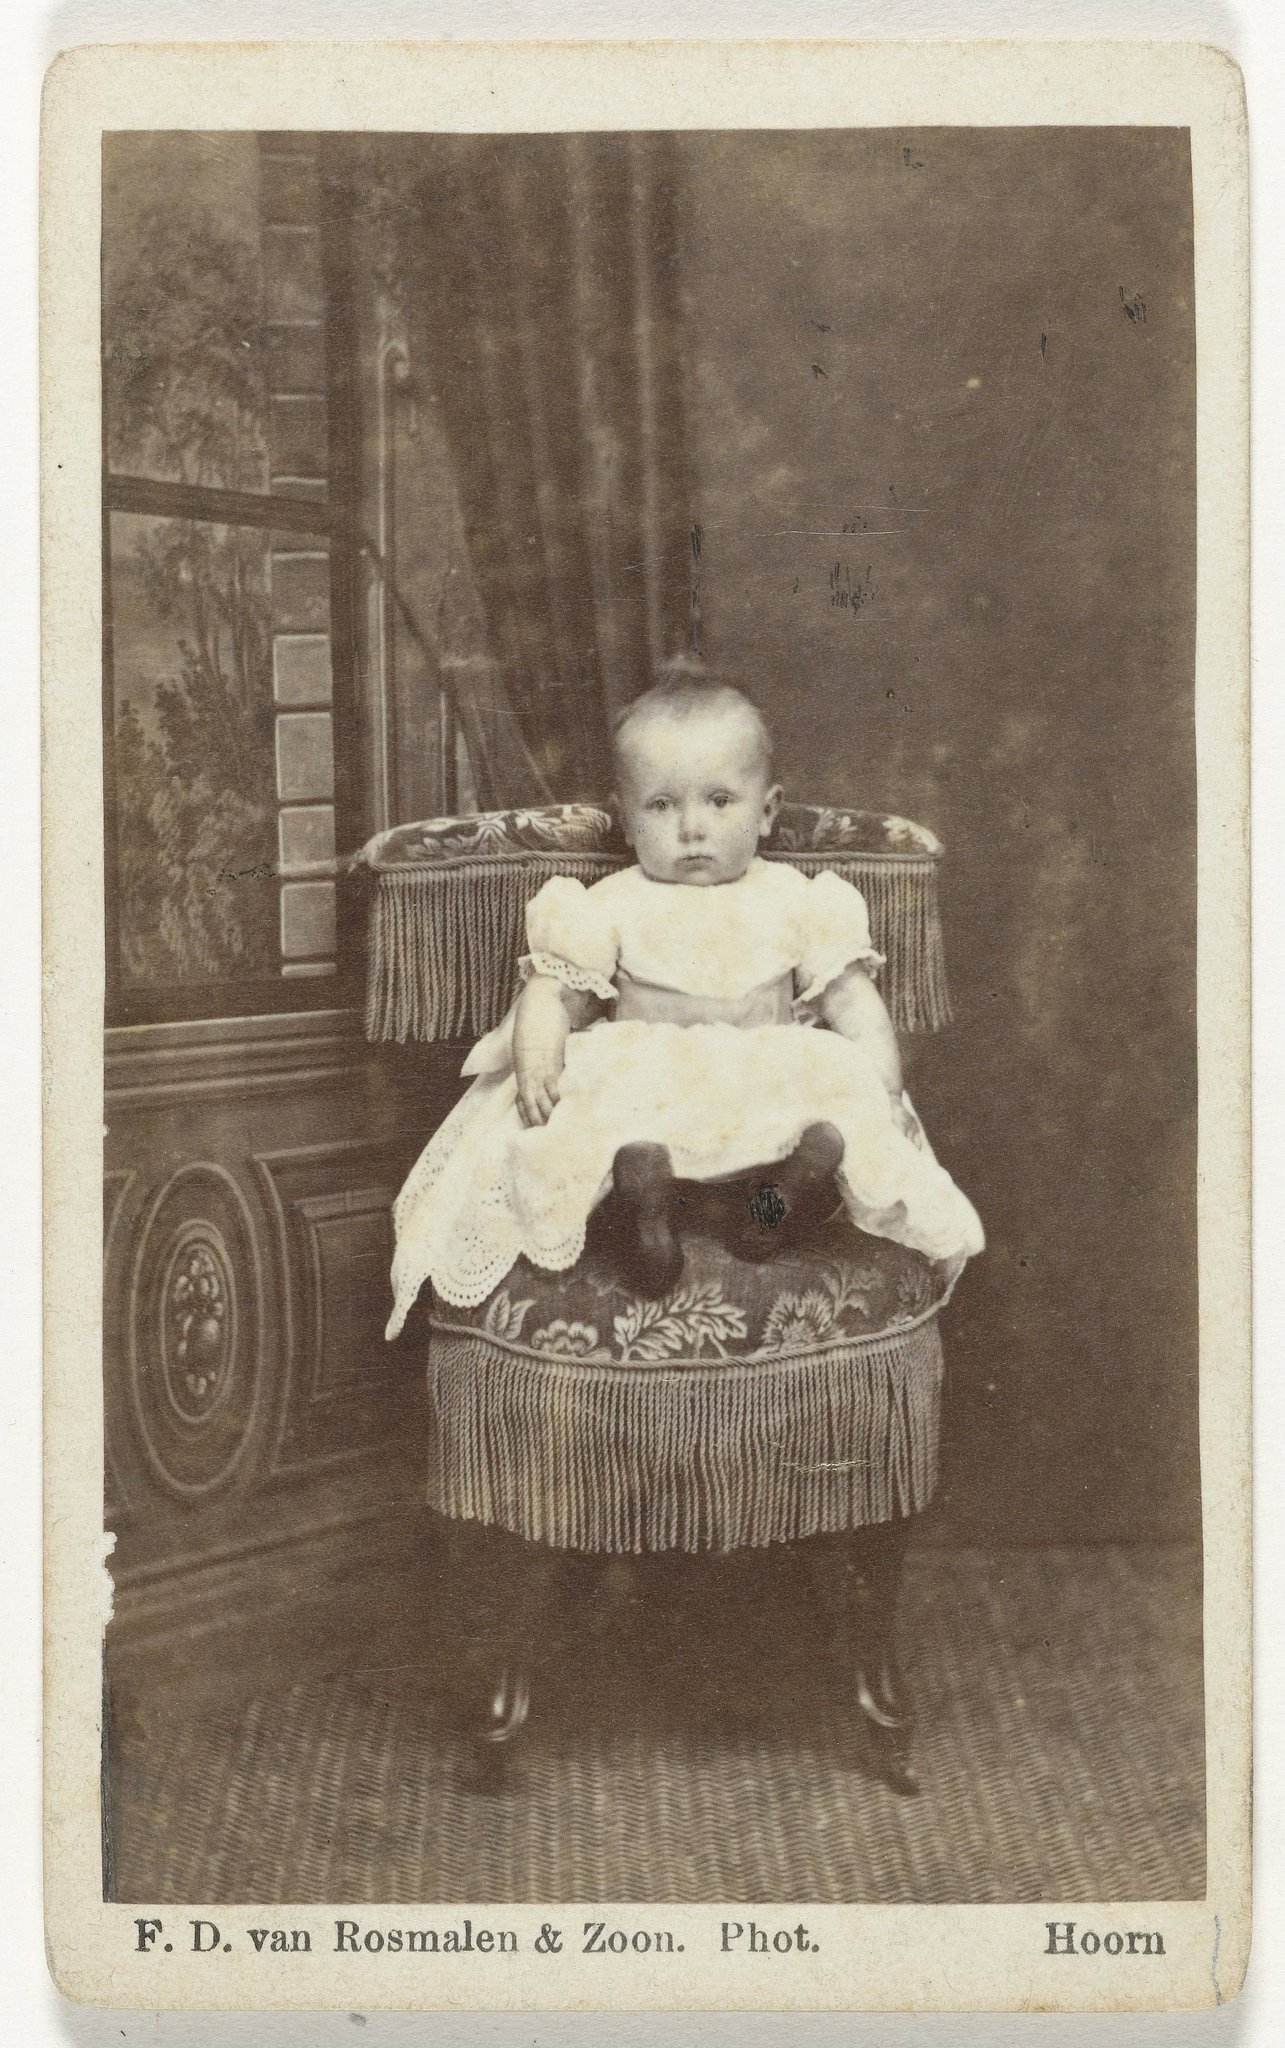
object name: photograph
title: Portret van een klein kind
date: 1870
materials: cardboard, paper, photographic support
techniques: albumen print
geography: hoorn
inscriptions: address: ‘Photographie/F.D. van Rosmalen & Zoon./Nieuwesteeg/Hoorn’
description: Klein kind in licht jurkje, zittend op een stoel met lange franjes naast een raam.